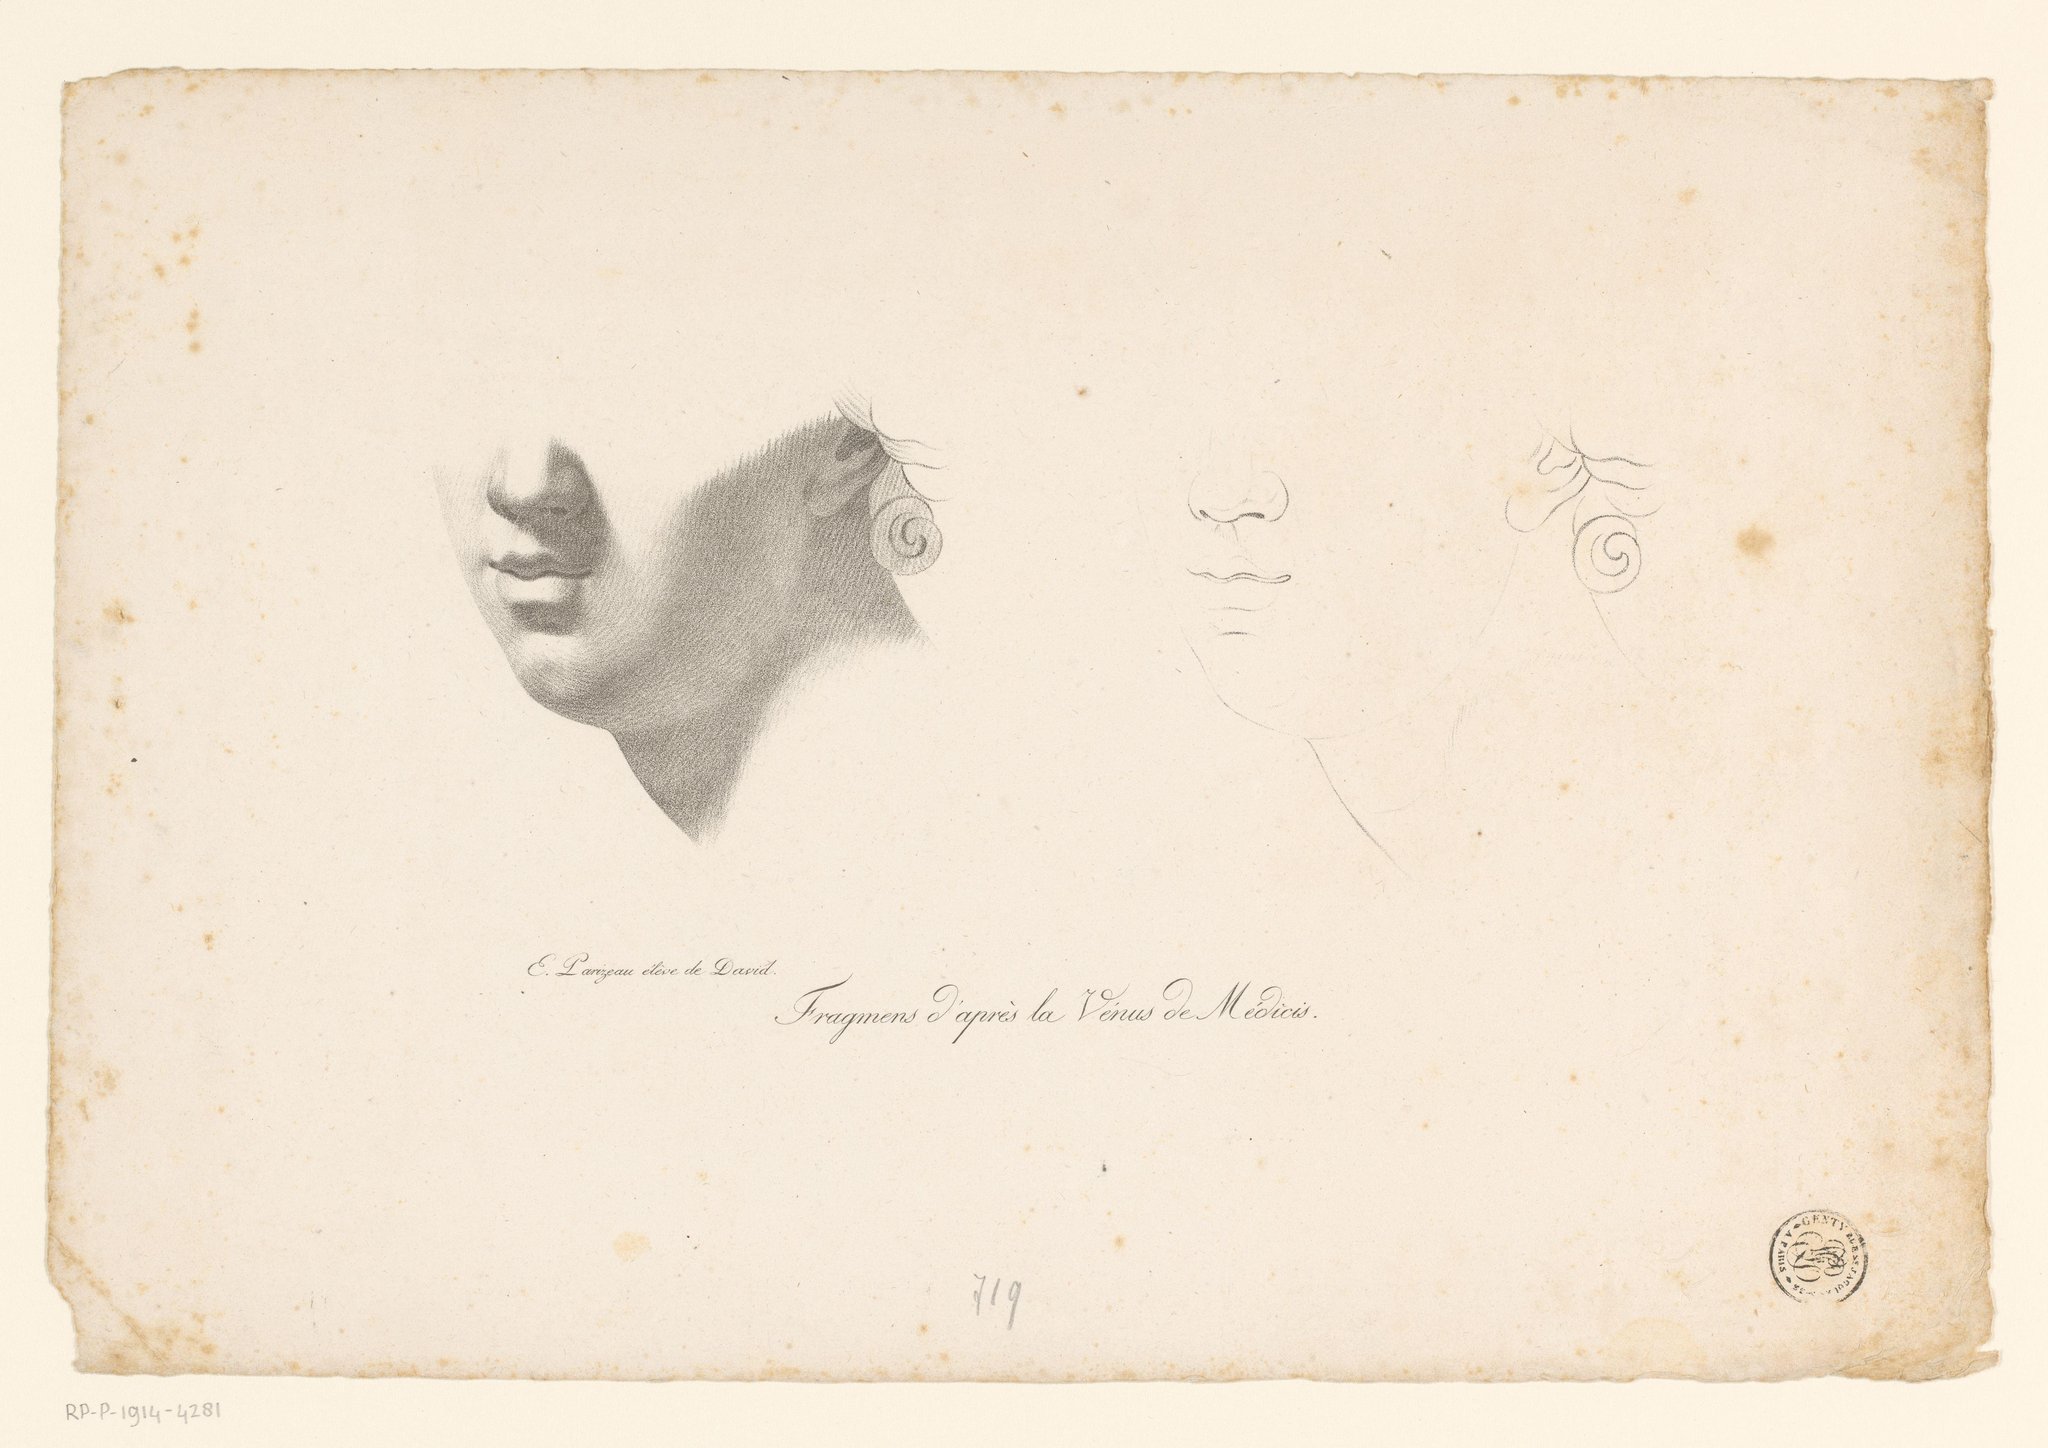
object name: print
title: Fragmens d'après la Vénus de Médicis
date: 1814-1852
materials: paper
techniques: lithograph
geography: paris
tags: piece of sculpture, reproduction of a piece of sculpture, (story of) venus (aphrodite)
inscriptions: collector's mark: Lugt 2228, stamp: ‘GENTY rue st. Jacques 33 A Paris’